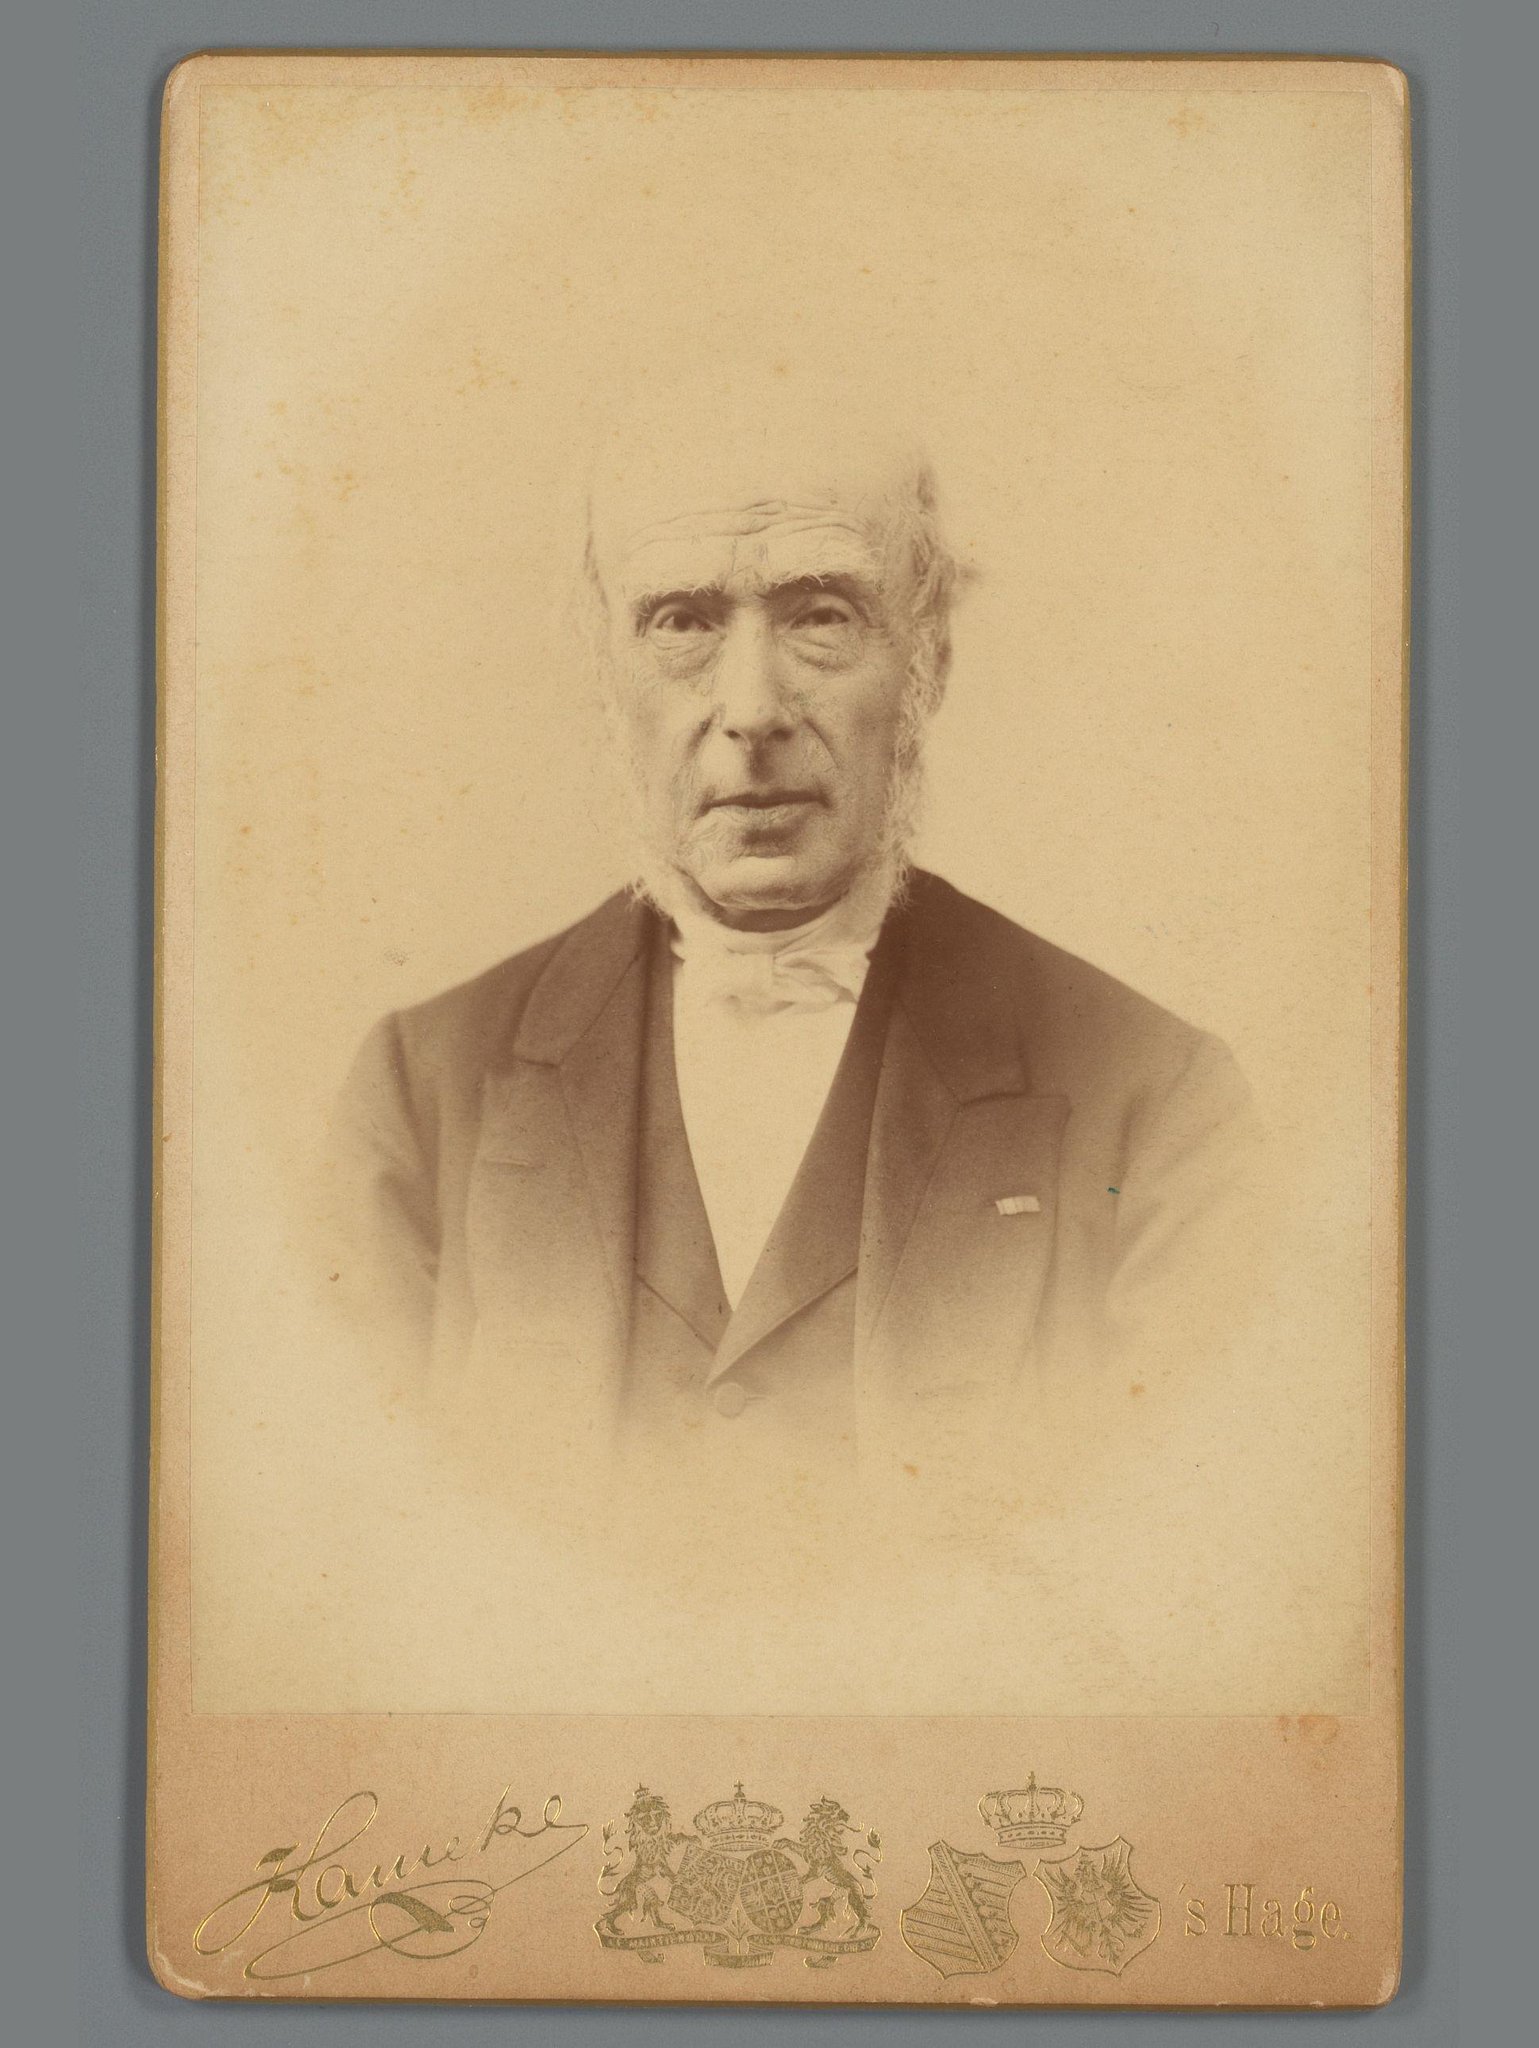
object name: cabinet photograph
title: Portret van Eduard Isaac Asser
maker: kameke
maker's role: painter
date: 1883-1894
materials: cardboard, photographic support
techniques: albumen print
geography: the hague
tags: eduard isaac asser, historical persons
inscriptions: inscription: ‘Kameke/ Portretschilder Hofphotograph/ van H.H M.M. den Koning en Koningin/ der Nederlanden./ en van H.K.H. Mevrouw de Prinses Albert/ von Saksen-Altenburg/ s'Gravenhage/ Javastraat No 20/ bij de Alexanderstraat’, inscription: ‘Mr. E. I. Asser’